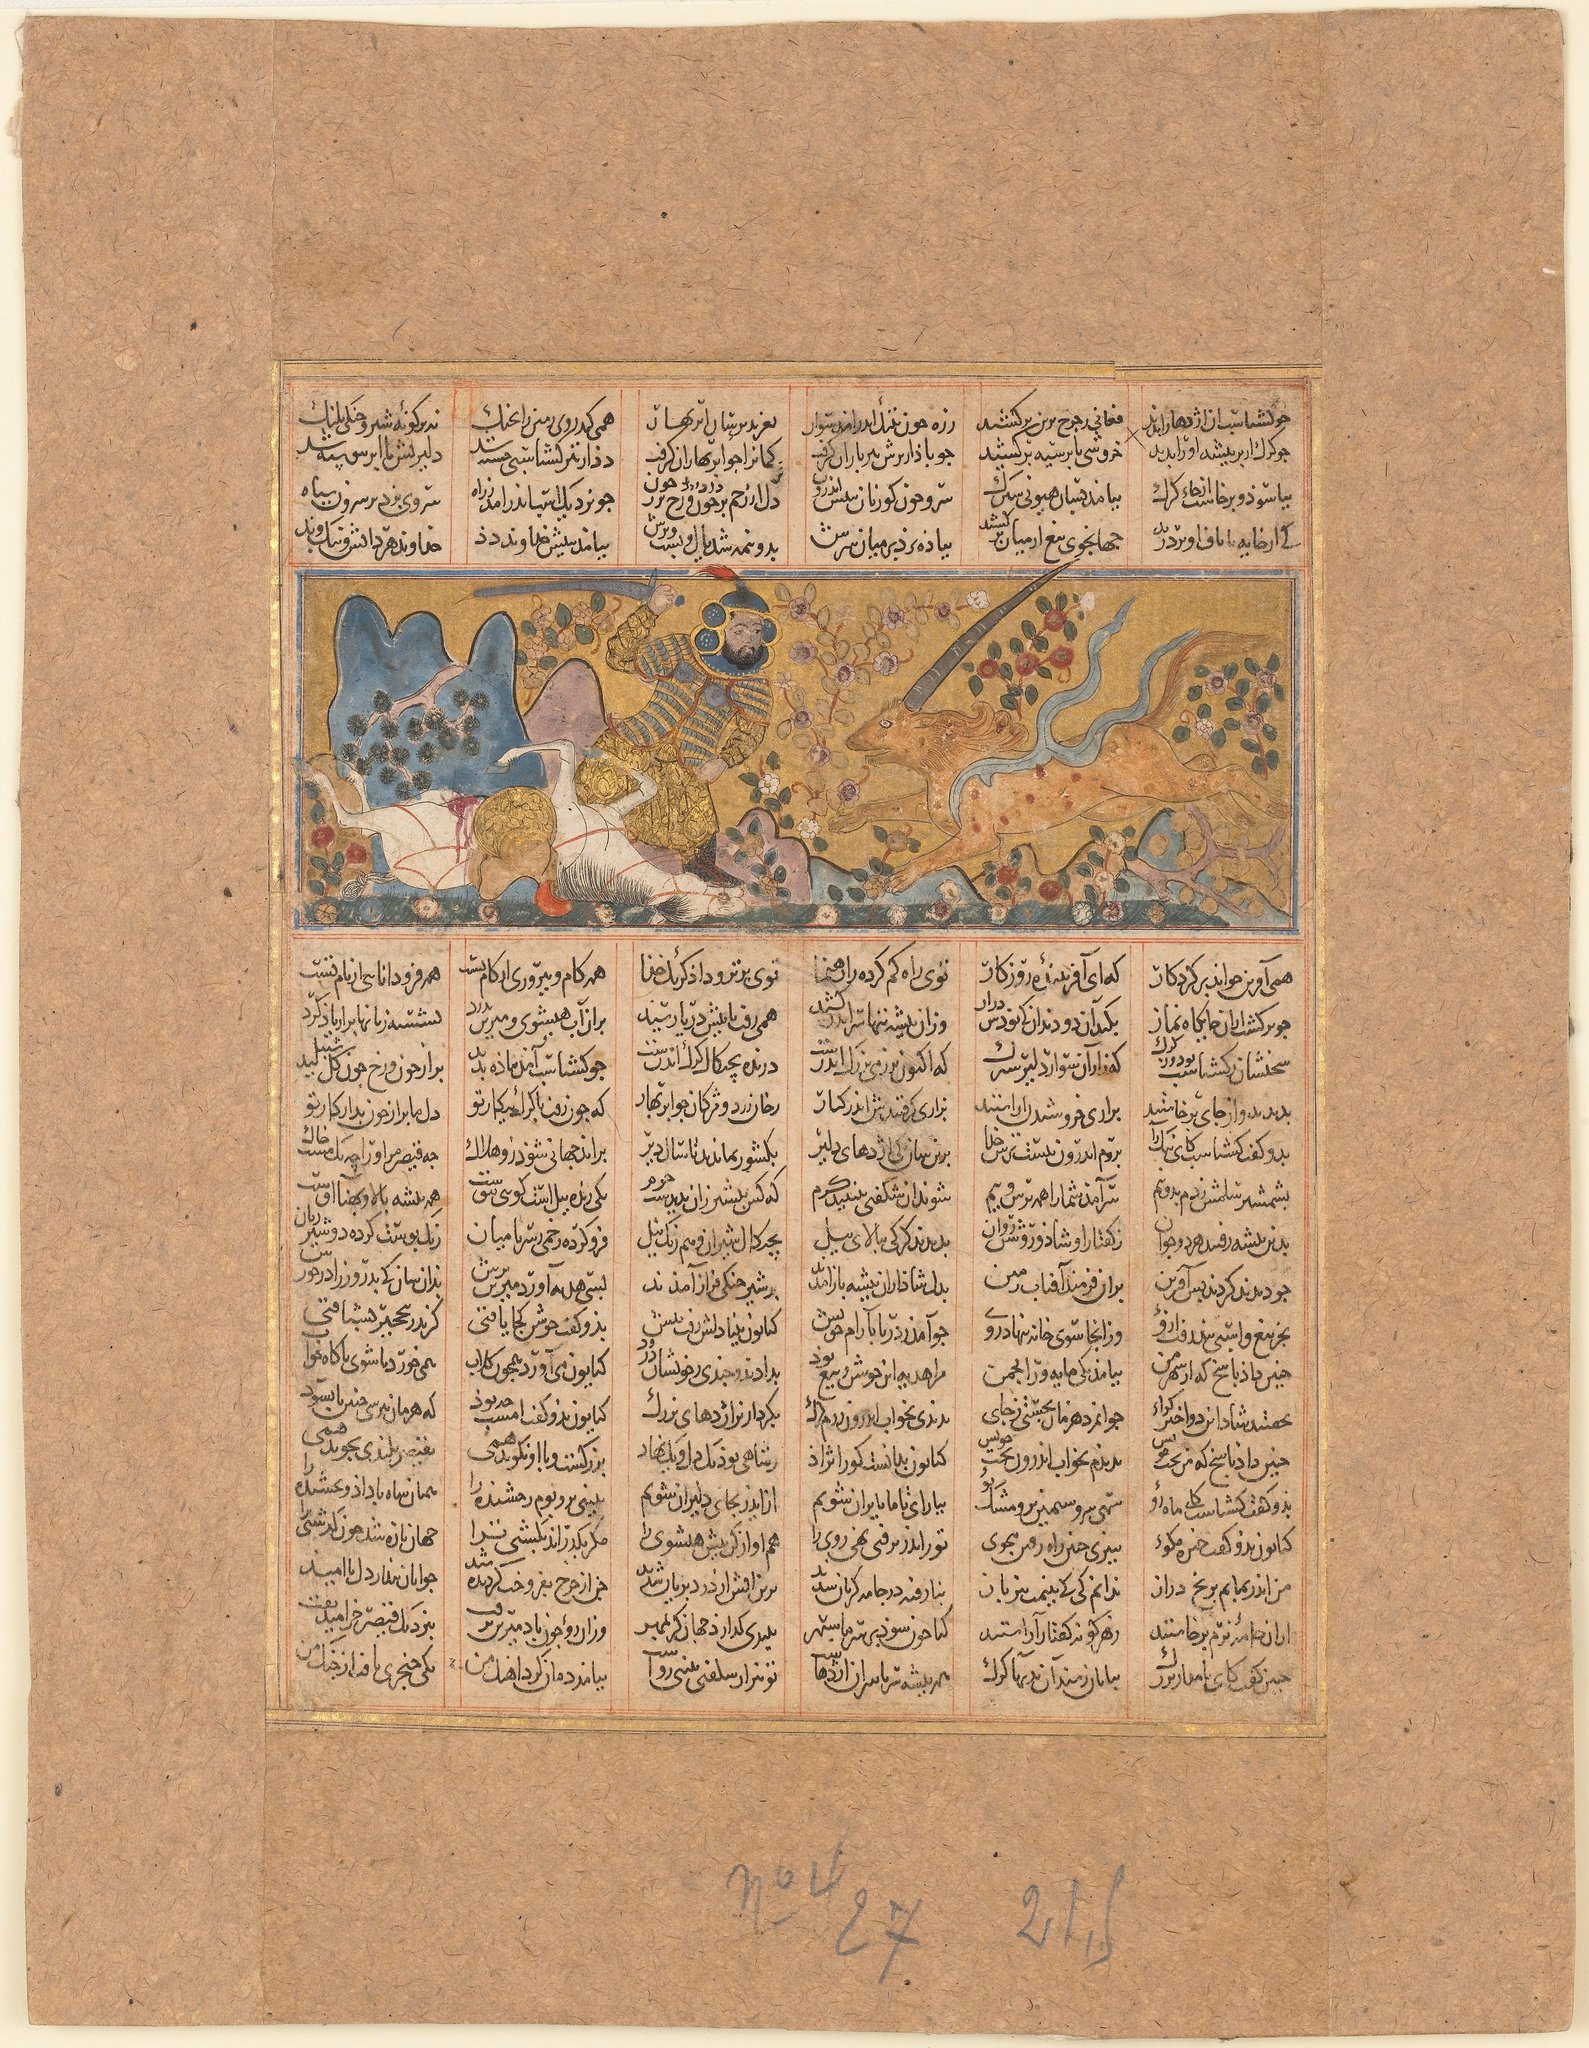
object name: folio from an illustrated manuscript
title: "Gushtasp Kills the Wolf of Fasiqun", Folio from a Shahnama (Book of Kings)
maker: abu'l qasim firdausi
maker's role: author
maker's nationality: iranian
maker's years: 935-1020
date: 1300-1330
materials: gold, ink, paper, silver, watercolor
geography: iran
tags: animals,men,hunting,horses,calligraphy